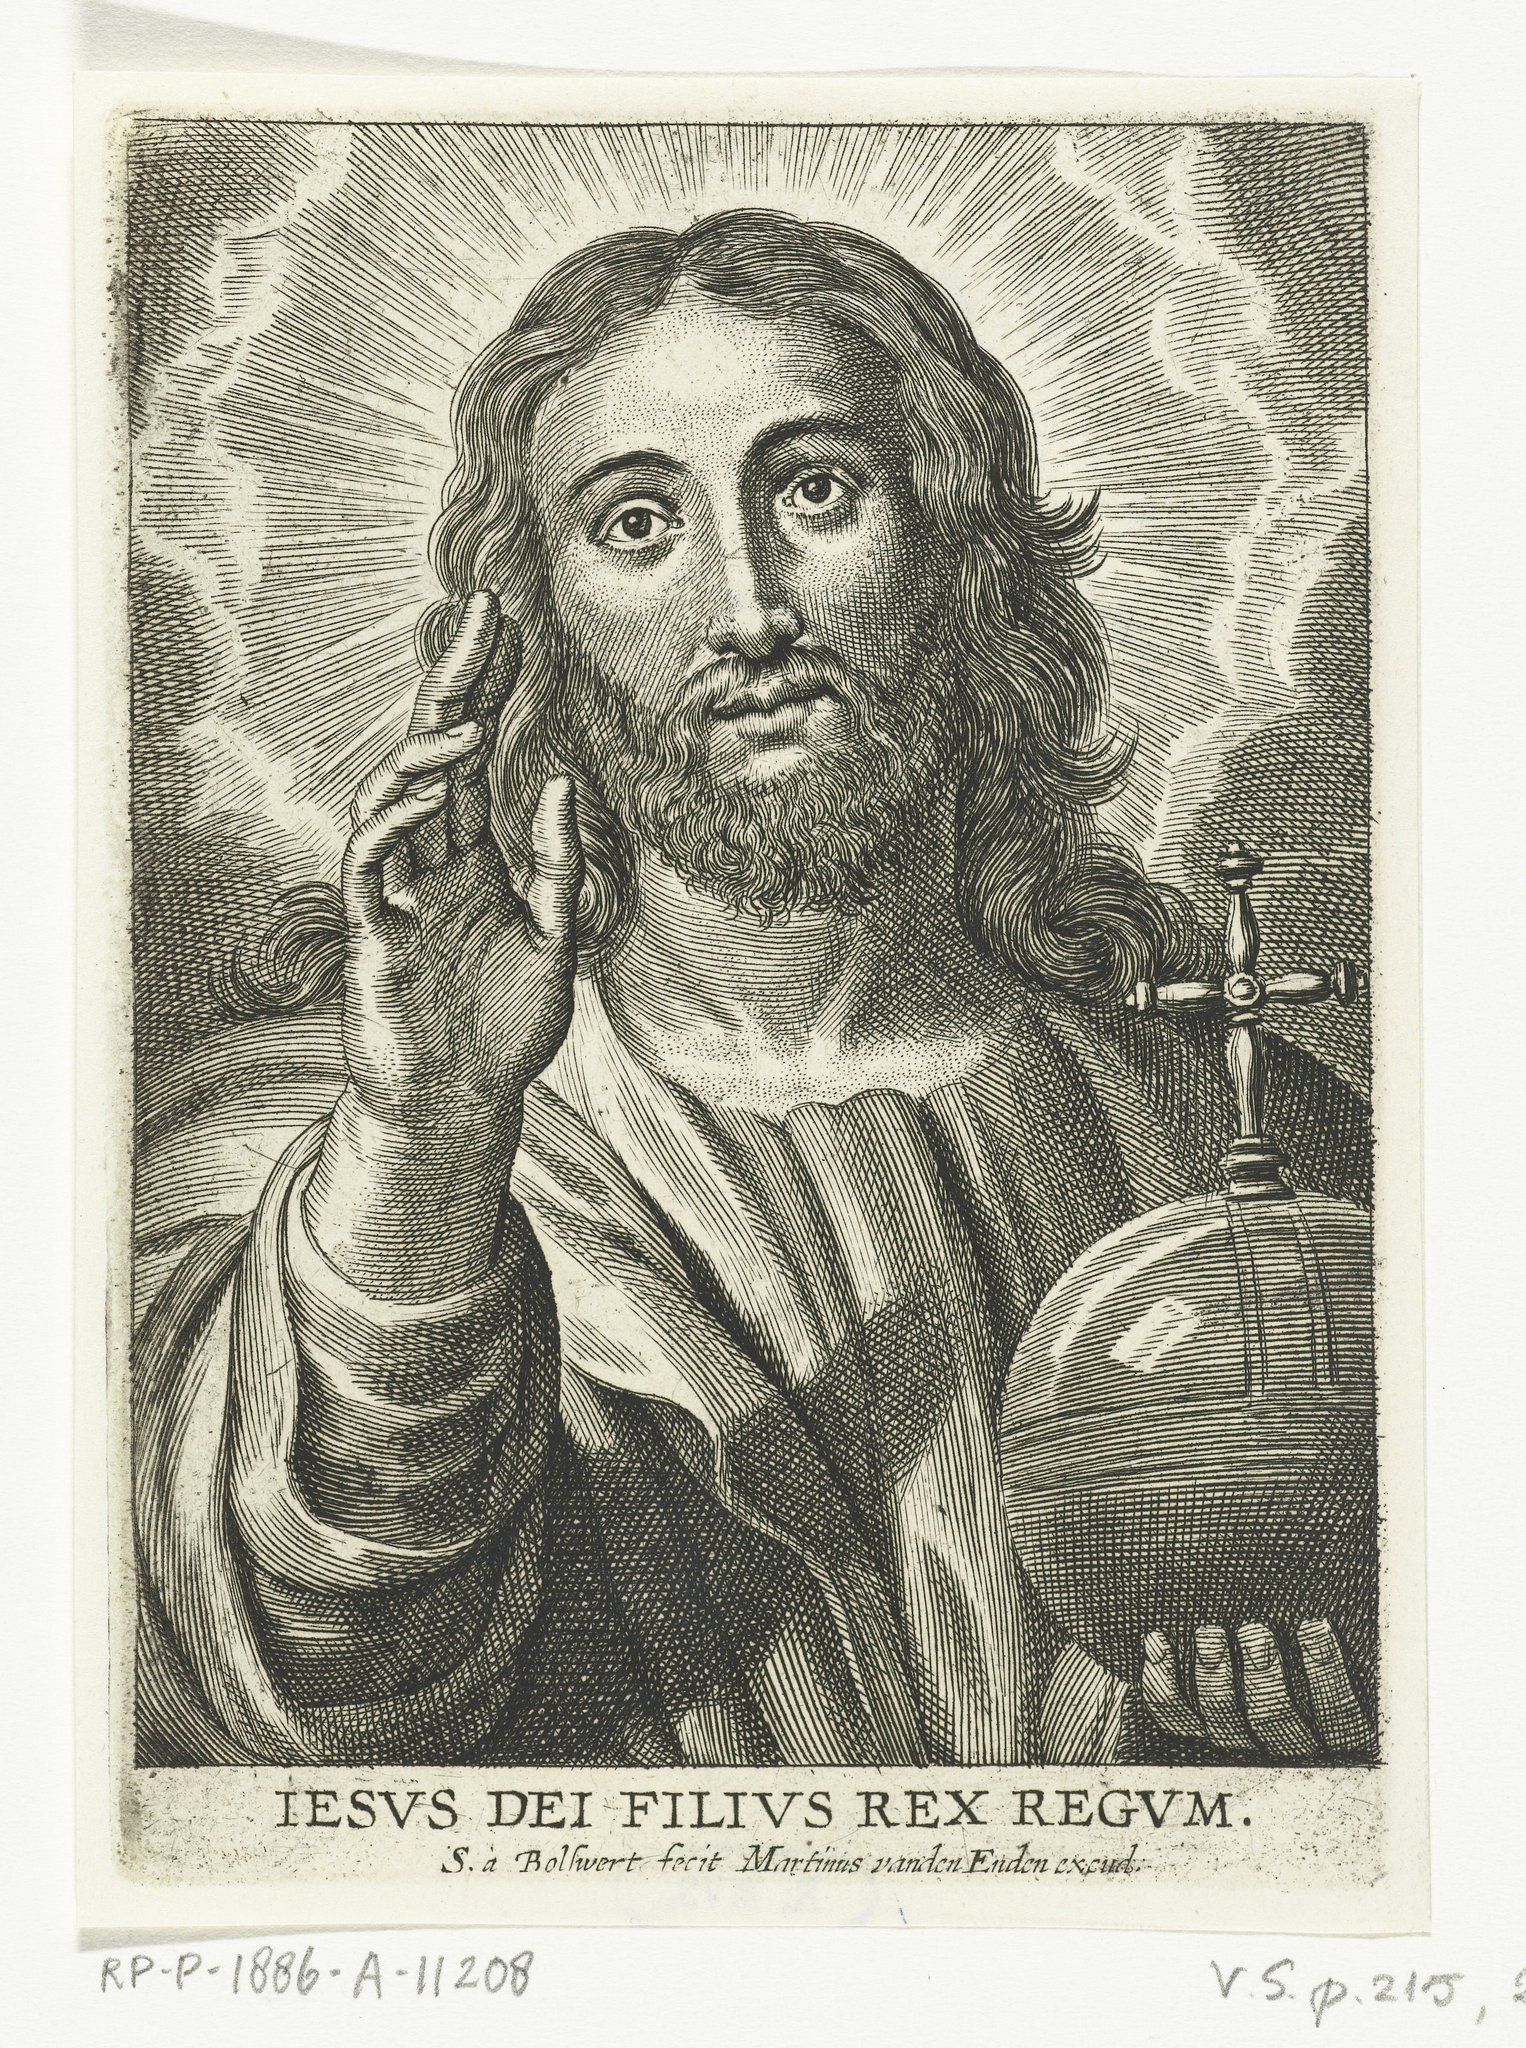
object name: print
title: Iesvs dei filivs Rex regvm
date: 1596-1659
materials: paper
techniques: engraving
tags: 'salvator mundi', making a blessing gesture; an orb in his hand or at his feet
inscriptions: collector's mark: Lugt 2228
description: Prent uit serie Vélins met negentig prenten naar ontwerp van Peter Paul Rubens. In de bronnen vinden we uiteenlopende gegevens over aantal en samenstelling van de serie. Hollstein hanteert het aantal van negentig prenten. De reeks Vélins in de collectie van het RMA bevat verschillende staten afkomstig uit meerdere uitgaven welke moeilijk te duiden zijn. Sommige dragen het originele adres van Schelte Adamsz. Bolswert als graveur en uitgever, op andere exemplaren is deze naam verwijderd (duidelijk zichtbaar!) en vervangen door de naam Cornelis Galle (II). De prenten met de naam van uitgever Galle zijn vaak opgewerkt. We treffen nog een andere naam van een uitgever bij enkele prent aan: Martien van den Enden. Herkomst uit meerdere uitgaven spreekt ook uit afwijkende opschriften in Nederlands en Latijn en variaties op dezelfde thema's welke misschien nooit langs elkaar in dezelfde serie gebruikt werden.